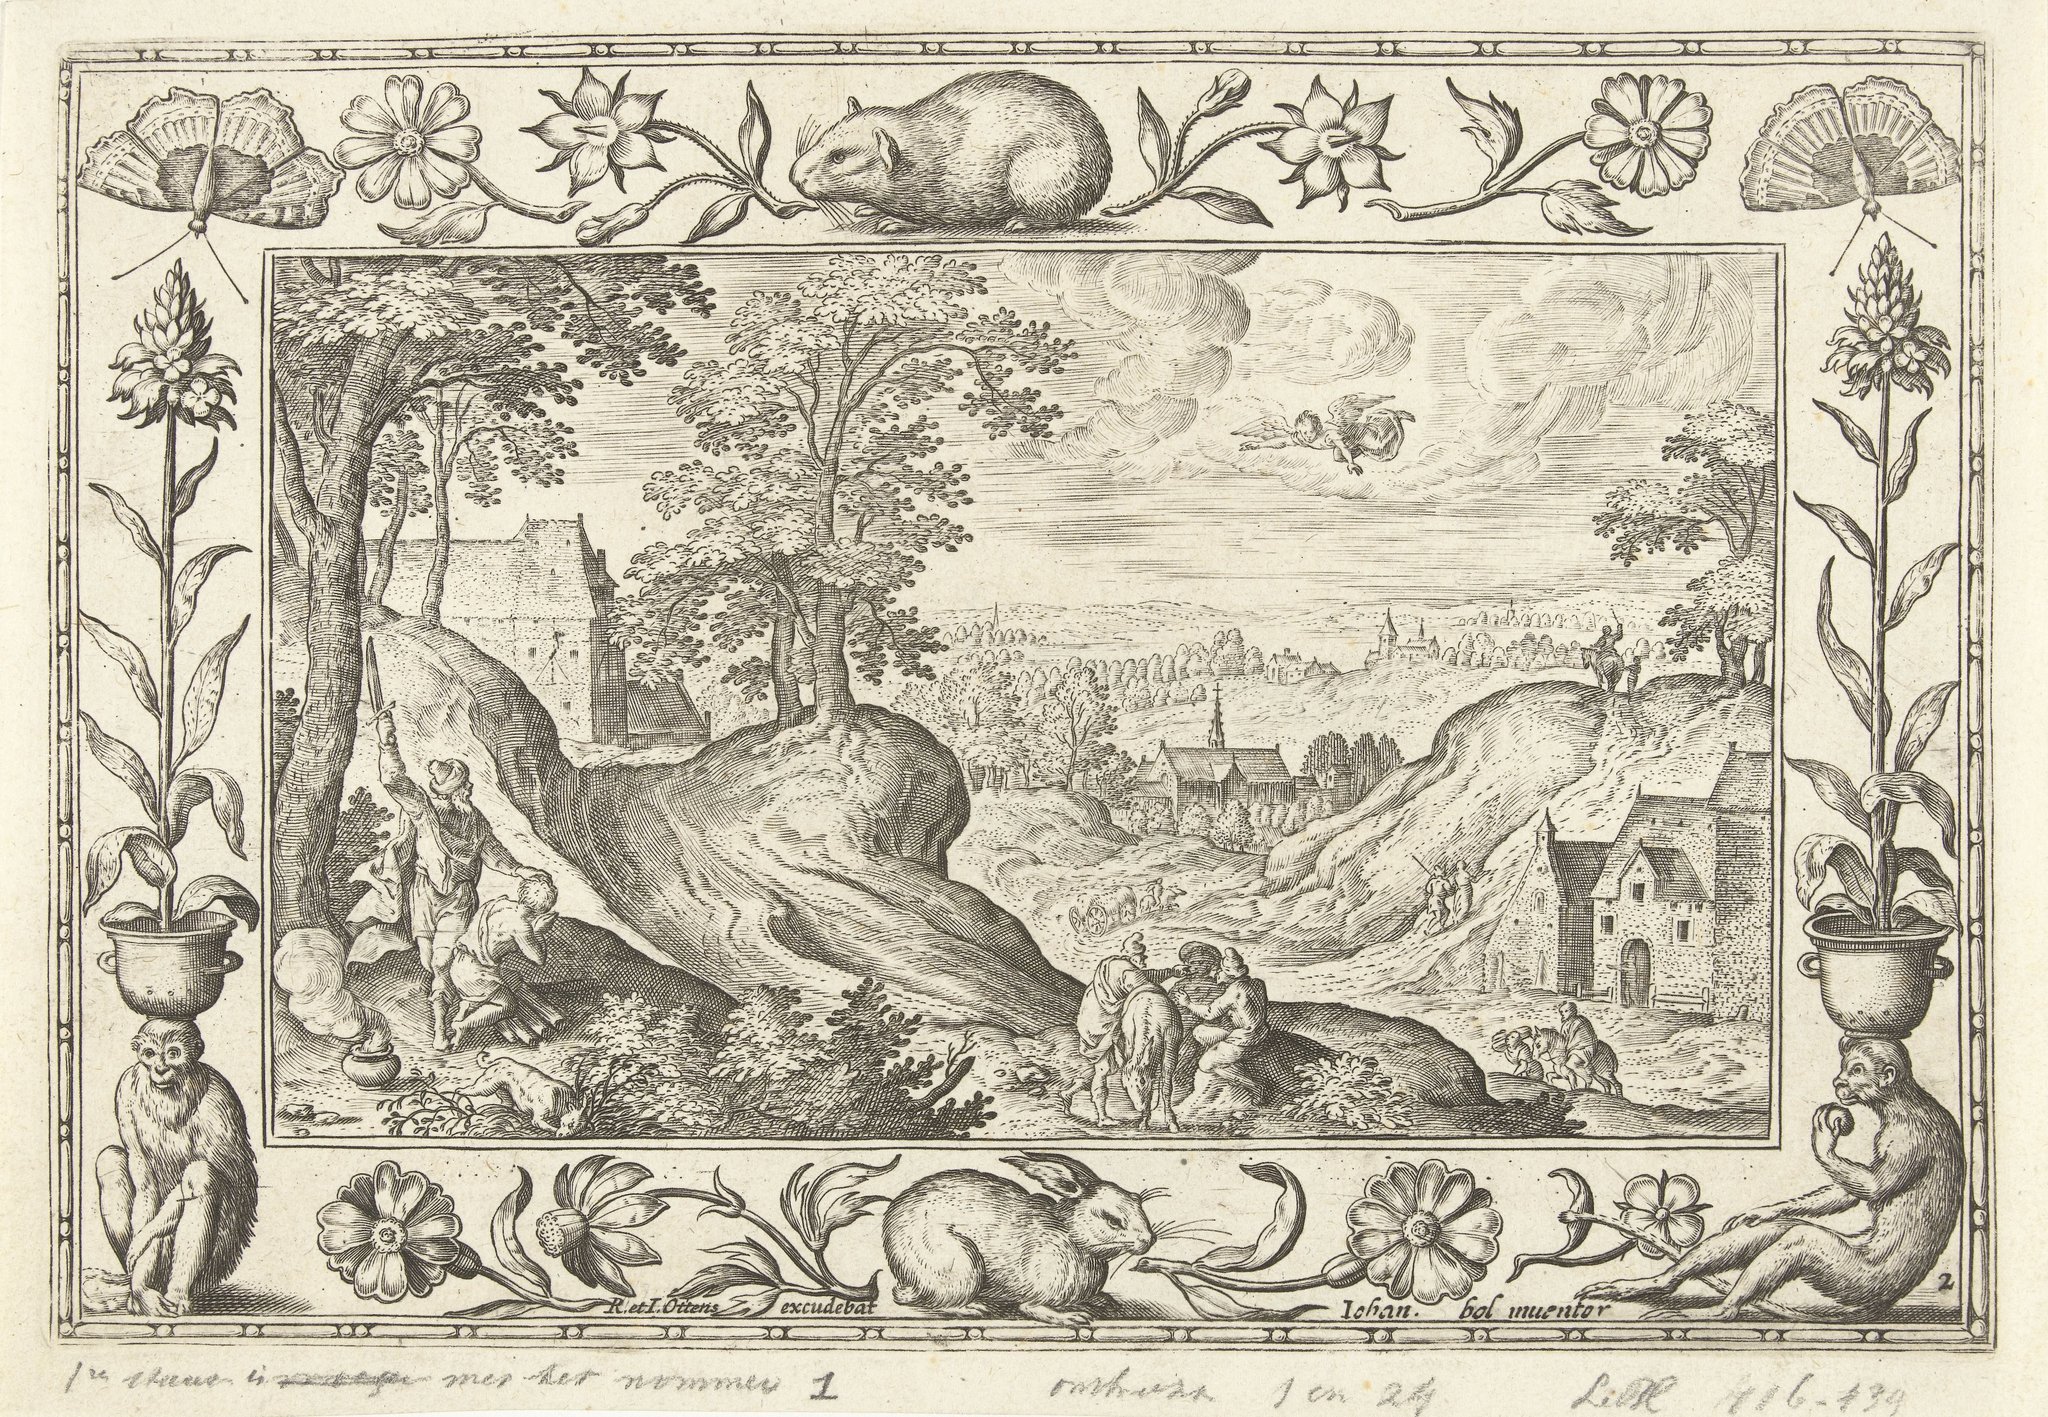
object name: print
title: Abraham offert Isaak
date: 1582-1586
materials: paper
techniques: engraving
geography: antwerp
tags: dale, valley, a ram caught in a thicket is sacrificed instead of isaac, flowers (+ ornamental variants of plants), rodents: rabbit (+ ornamental variants of animals), rodents: rat (+ ornamental variants of animals), monkeys, apes (+ ornamental variants of animals)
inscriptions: collector's mark: Lugt 2228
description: Heuvelachtig landschap met links op de voorgrond Abraham die zijn zoon Isaak wil offeren. Een engel in de lucht verschijnt en verhindert het offer. De prent heeft een ornamentlijst met bloemen en dieren. Hij maakt deel uit van een vierentwintigdelige serie van landschappen met Bijbelse, mythologische scènes en jachttaferelen.